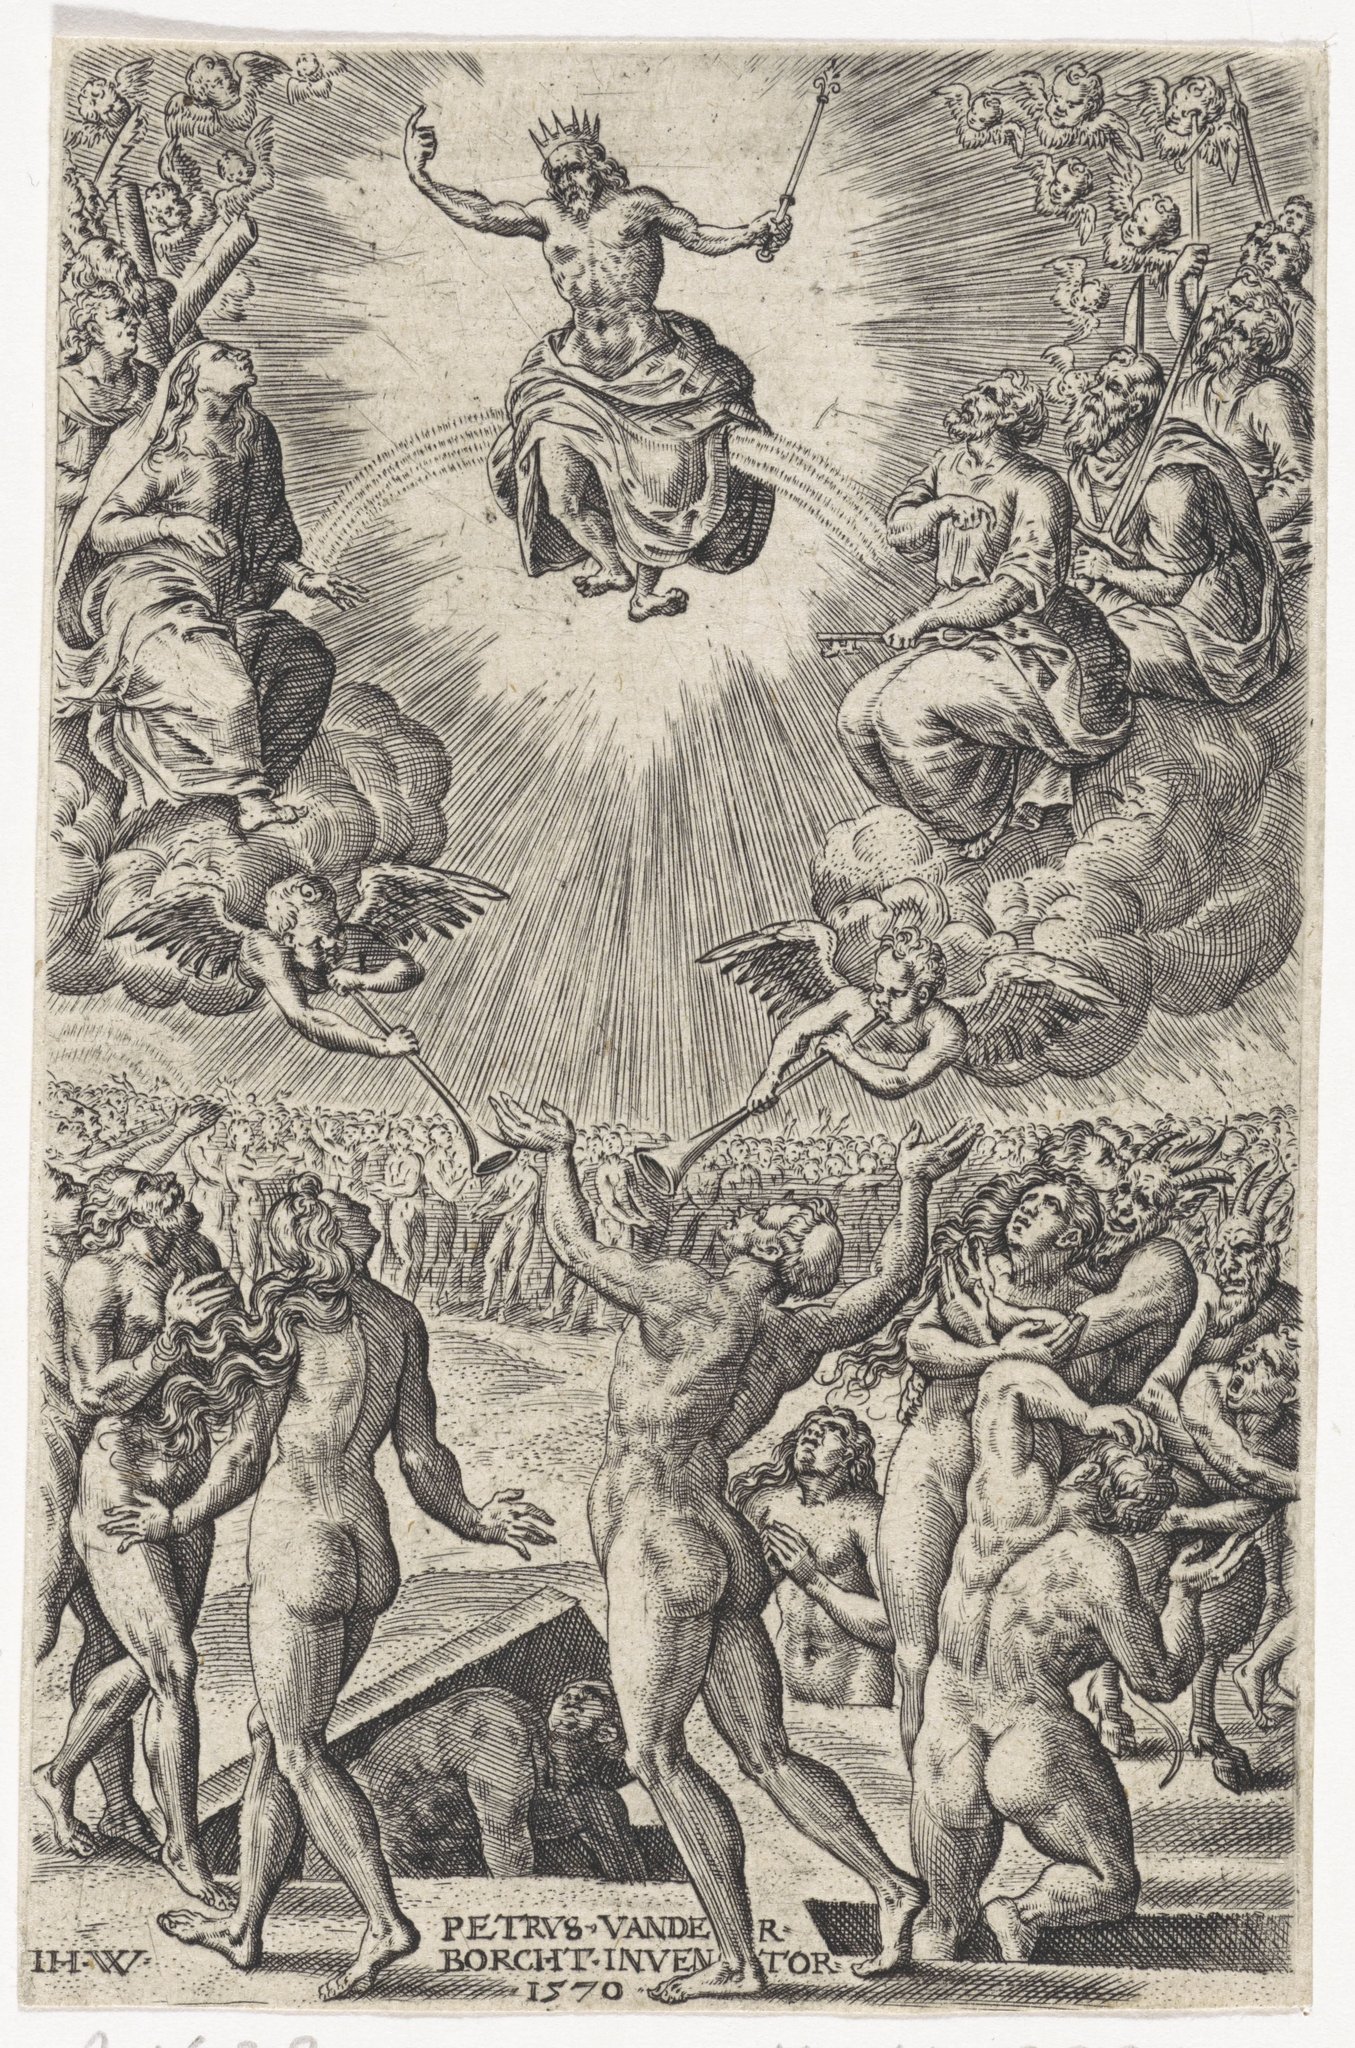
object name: print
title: Laatste Oordeel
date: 1570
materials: paper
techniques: engraving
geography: antwerp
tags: comprehensive representation of last judgement: christ (with sword and lily), often surrounded by elders and sometimes accompanied by mary and john the baptist, appears in the sky with trumpeting angels (and sometimes angels holding the instruments of the passion); after the resurrection of the dead the blessed are led to heaven by angels, and the damned are dragged into hell by devils, 'majestas domini': christ in mandorla seated on a rainbow or sphere and accompanied by the tetramorph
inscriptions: collector's mark: Lugt 2228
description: Christus zit als rechter op de regenboog. Hij wordt omgeven door cherubijnen en heiligen. Op aarde staan de mensen op uit hun graf.